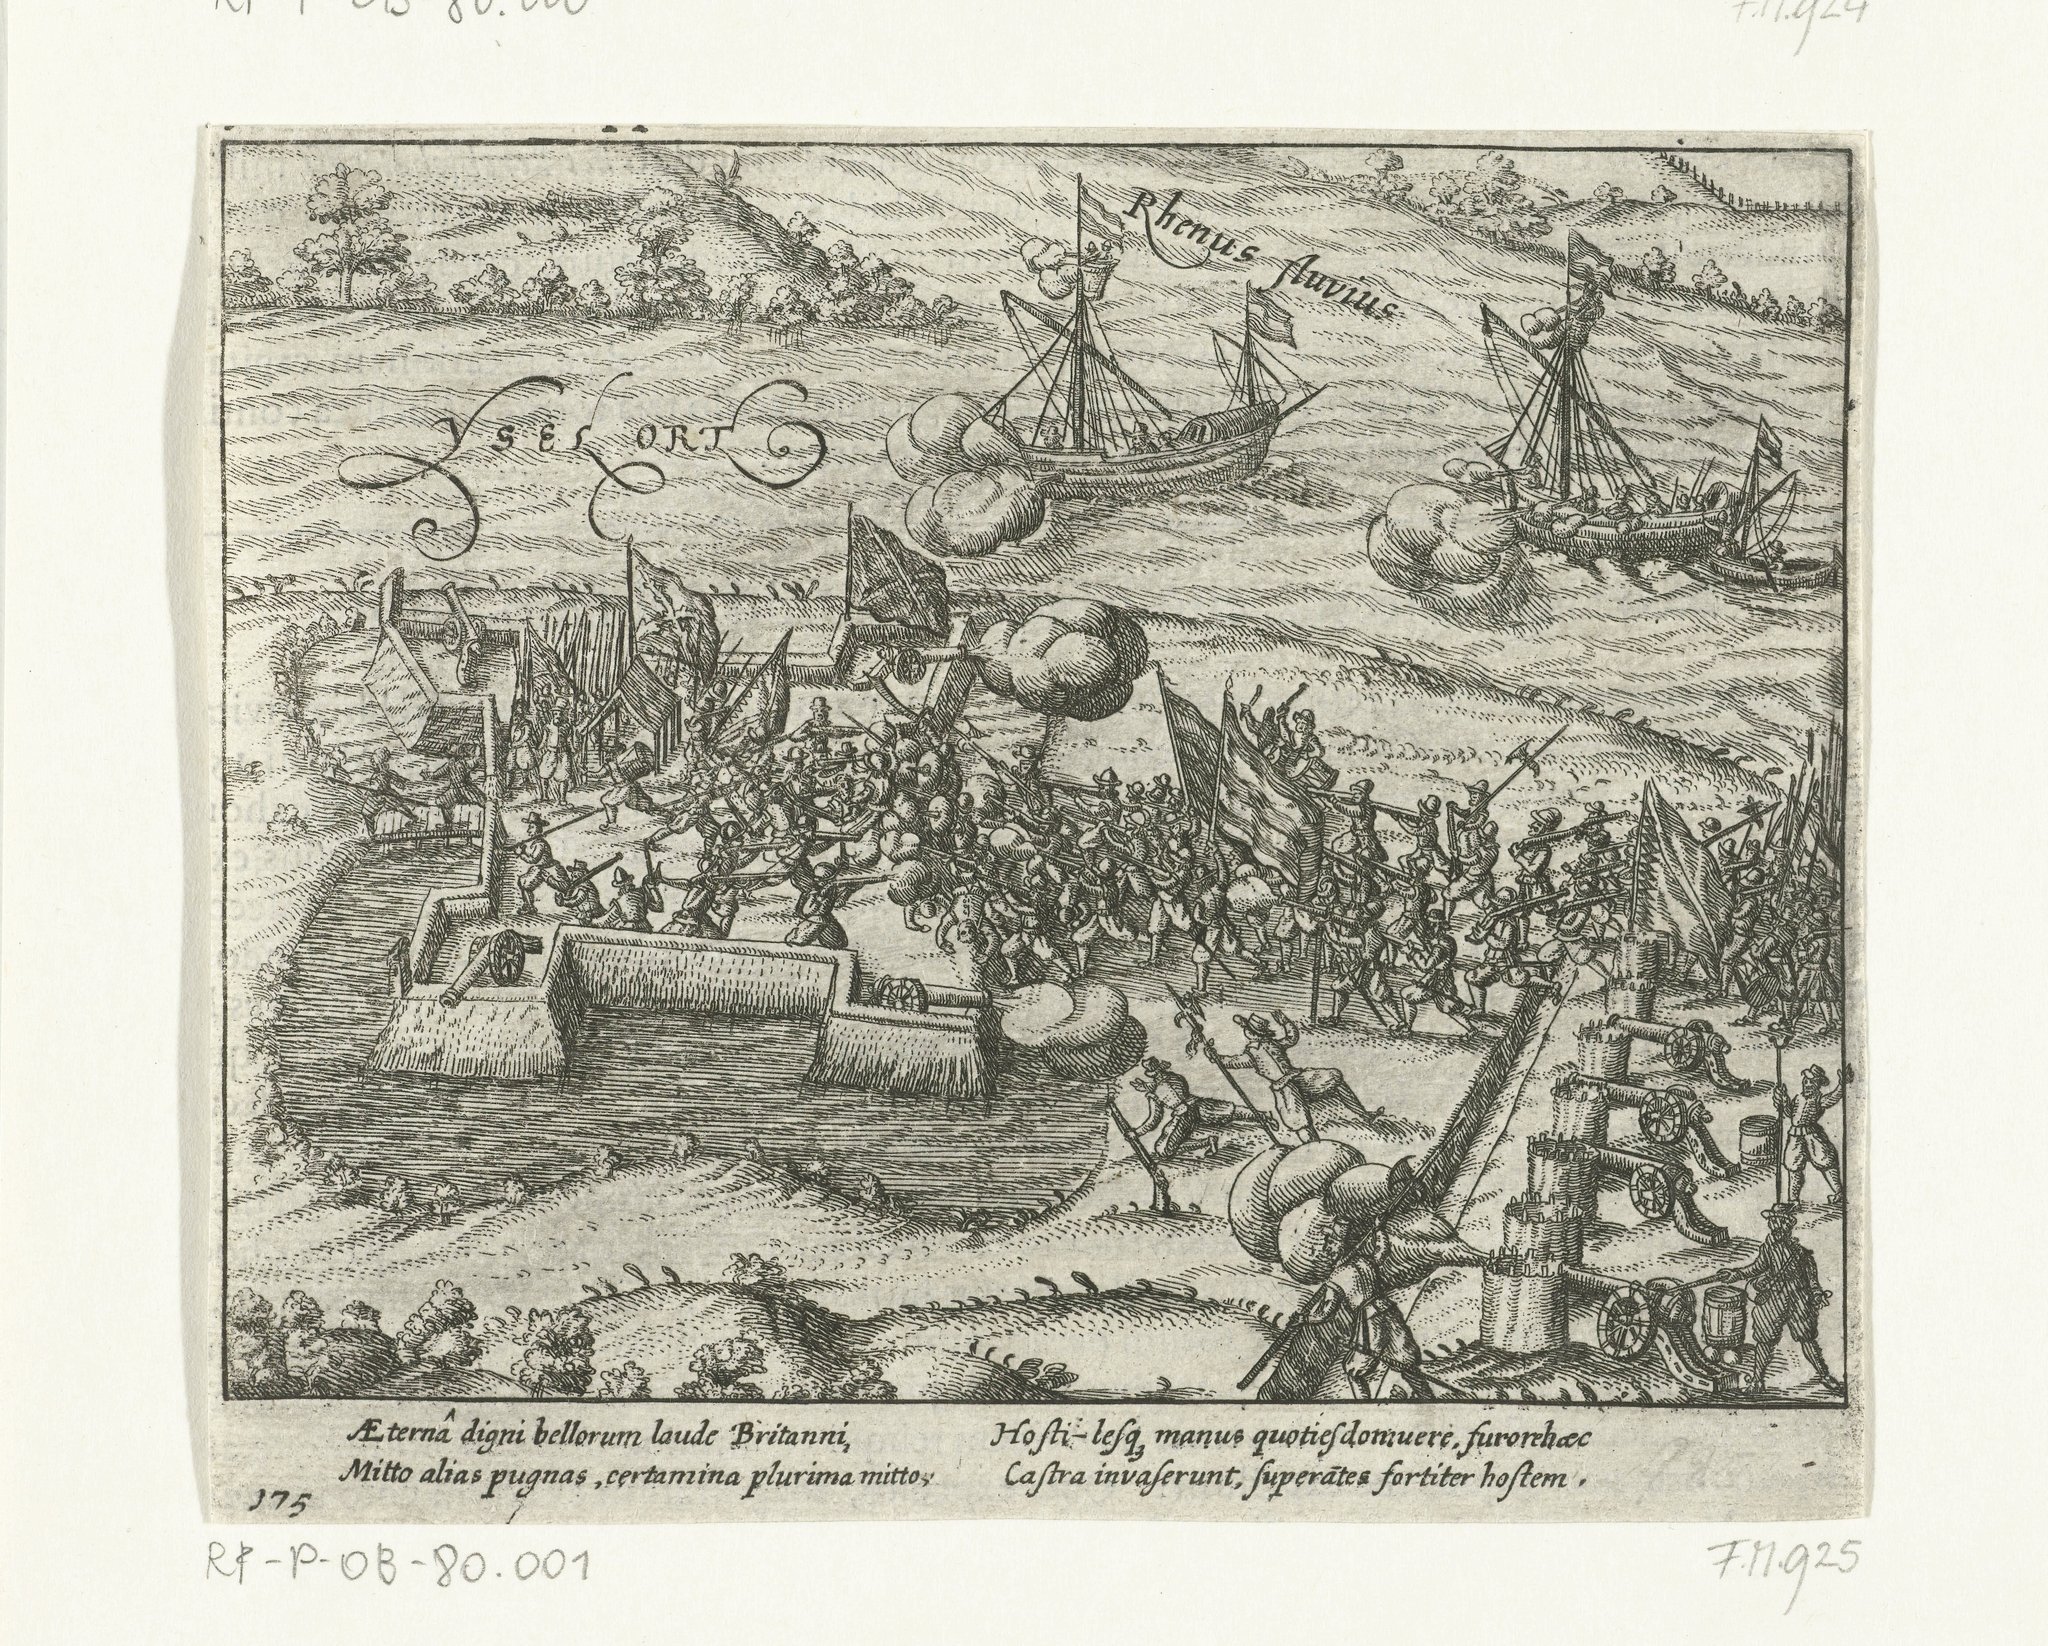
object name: history print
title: Inname van de schans IJsseloord bij Arnhem, 1585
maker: Anonymous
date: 1613-1615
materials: paper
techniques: etching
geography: northern netherlands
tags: capture of city (after the siege)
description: Verovering van de schans IJsseloord bij Arnhem, 10 november 1585, door Engelse en Duitse soldaten van het Staatse leger. Op de achtergrond de splitsing van de Rijn en de IJssel. Met onderschrift van 4 regels in het Latijn. Genummerd: 175. Bedrukt op achterzijde met tekst in het Latijn.